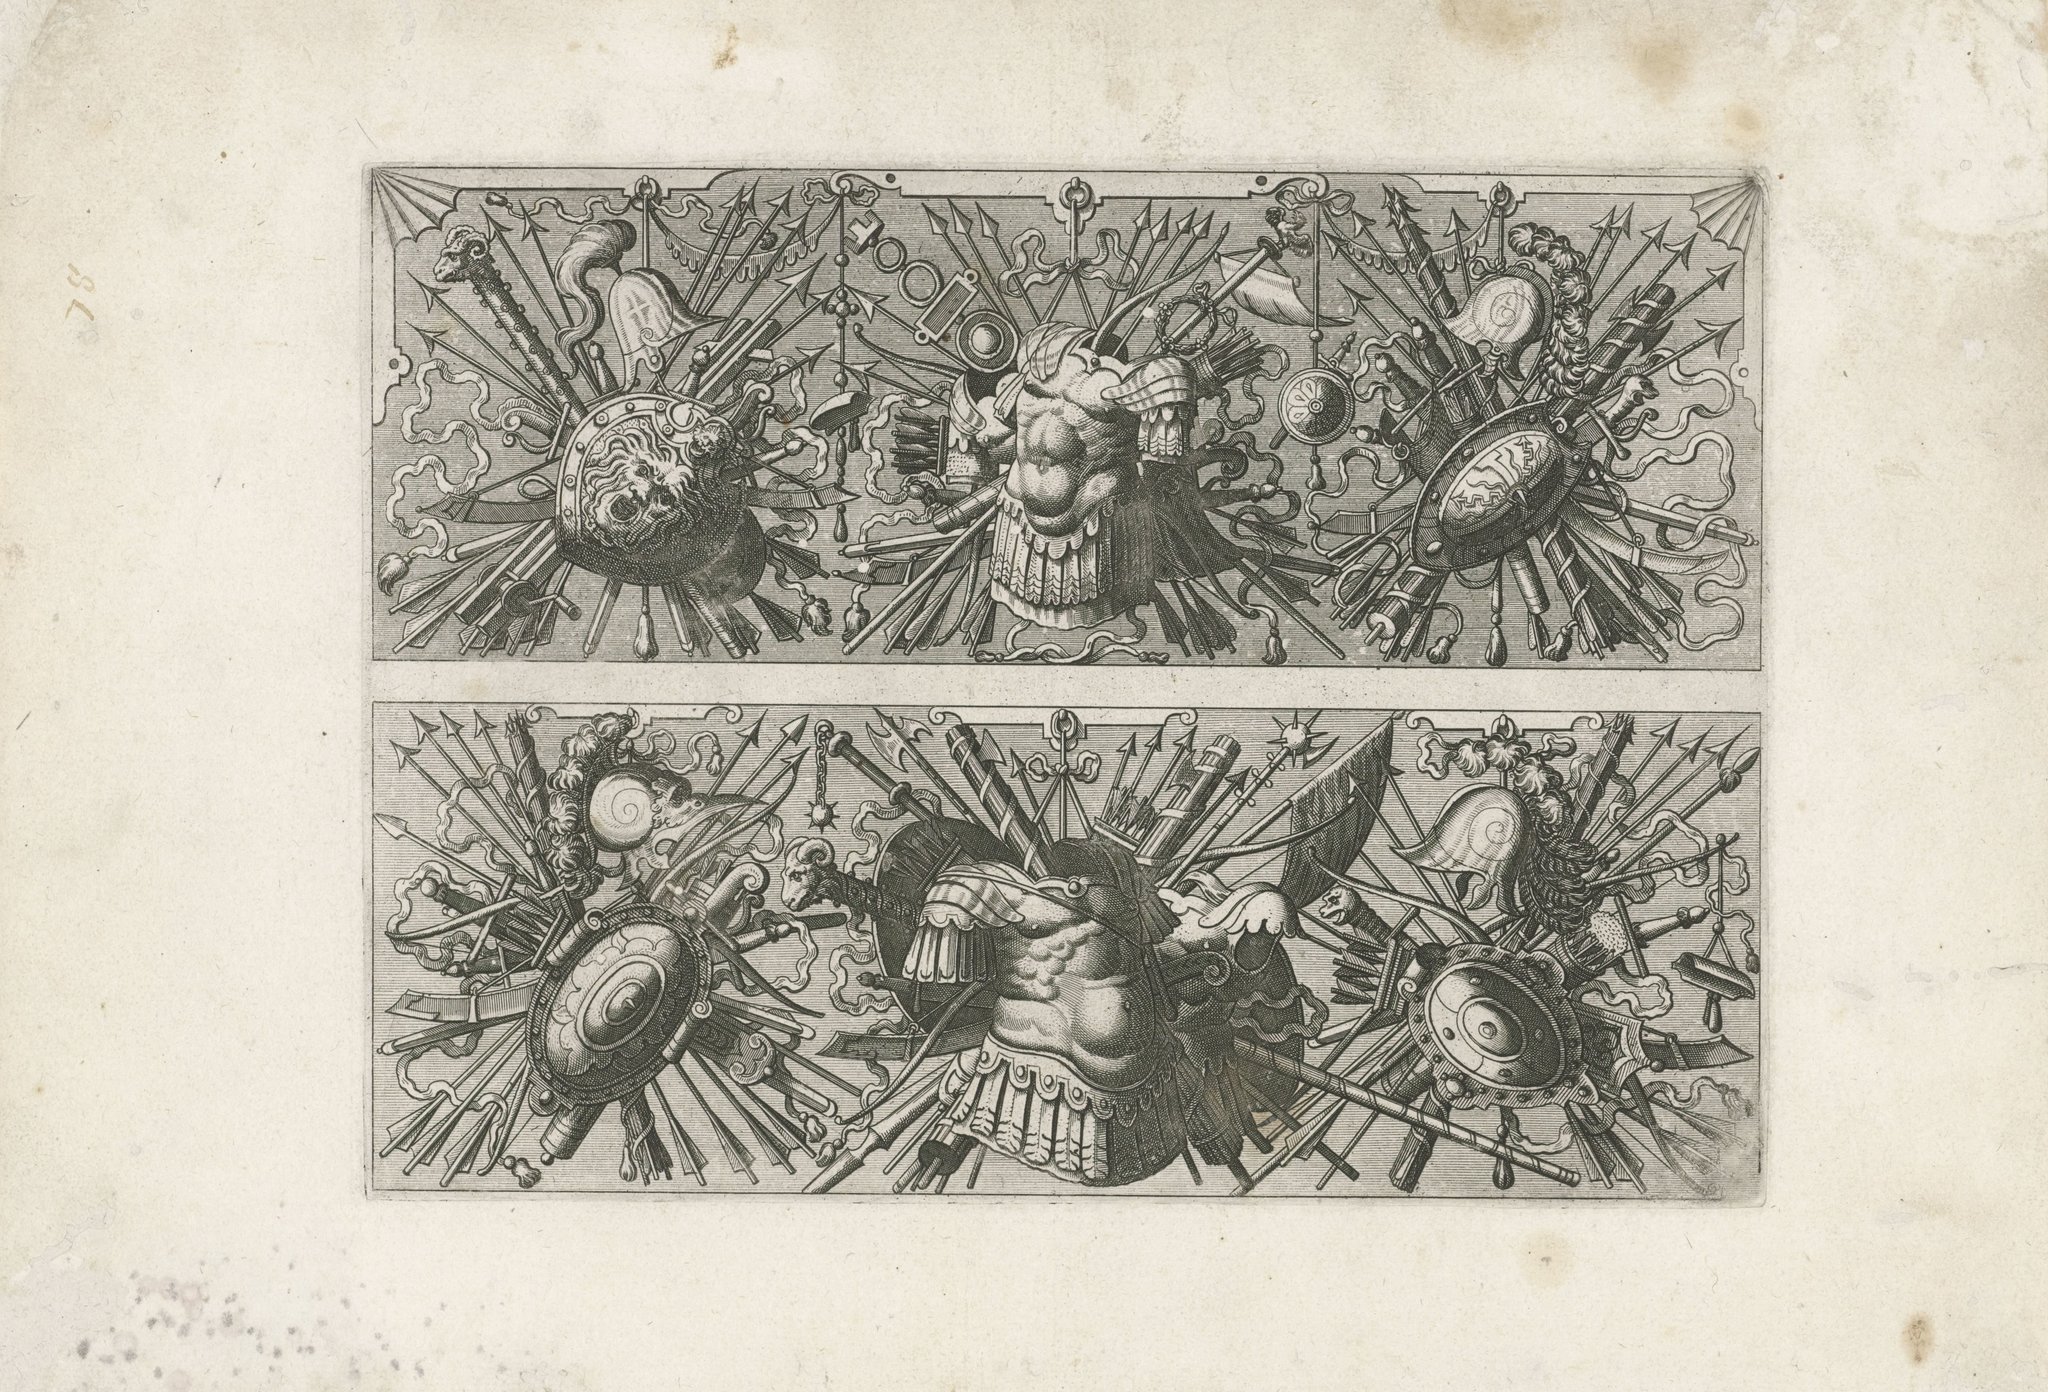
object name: ornament print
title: Panoplia sev armamentarium (...).consuevere Iohs Vredeman de Vriese inventor Gerard de Jode excudebat Anno 1572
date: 1558-1572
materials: paper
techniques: etching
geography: netherlands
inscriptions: inscription: ‘.’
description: Twee horizontale trofeeën met in het midden een harnas, geflankeerd door schilden, helmen, lansen, speren en vaandels (Hollst. 347-I)